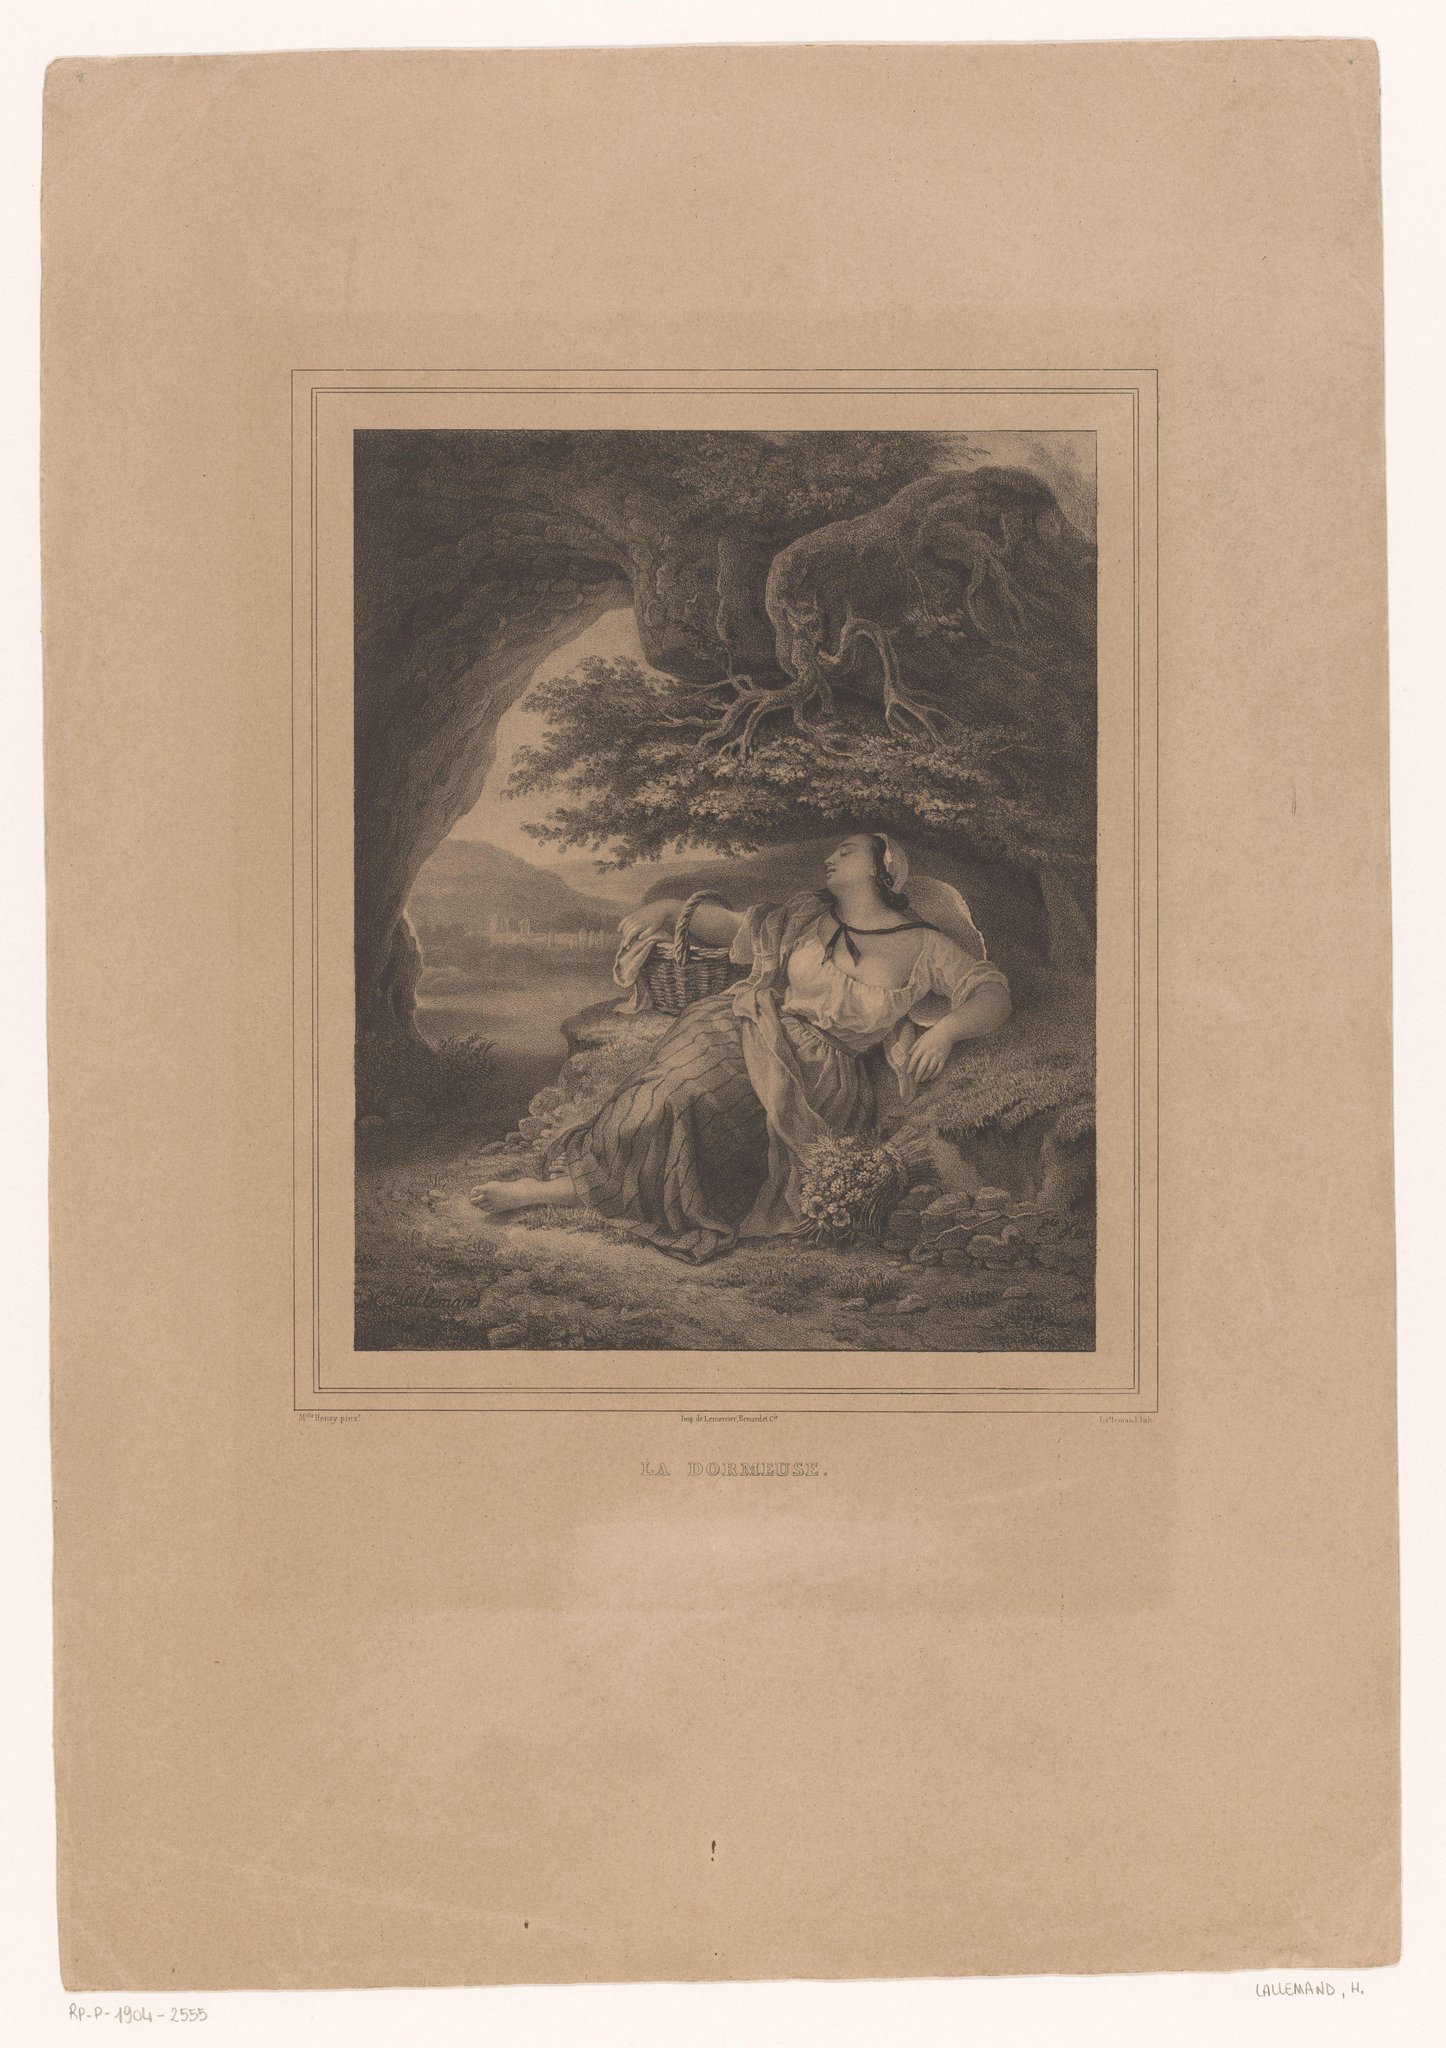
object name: print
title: Slapende vrouw onder wortelstelsel van een boom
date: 1839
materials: paper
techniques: lithograph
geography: paris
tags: adult woman, sleeping on the ground - bb - out of doors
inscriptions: collector's mark: Lugt 2228a